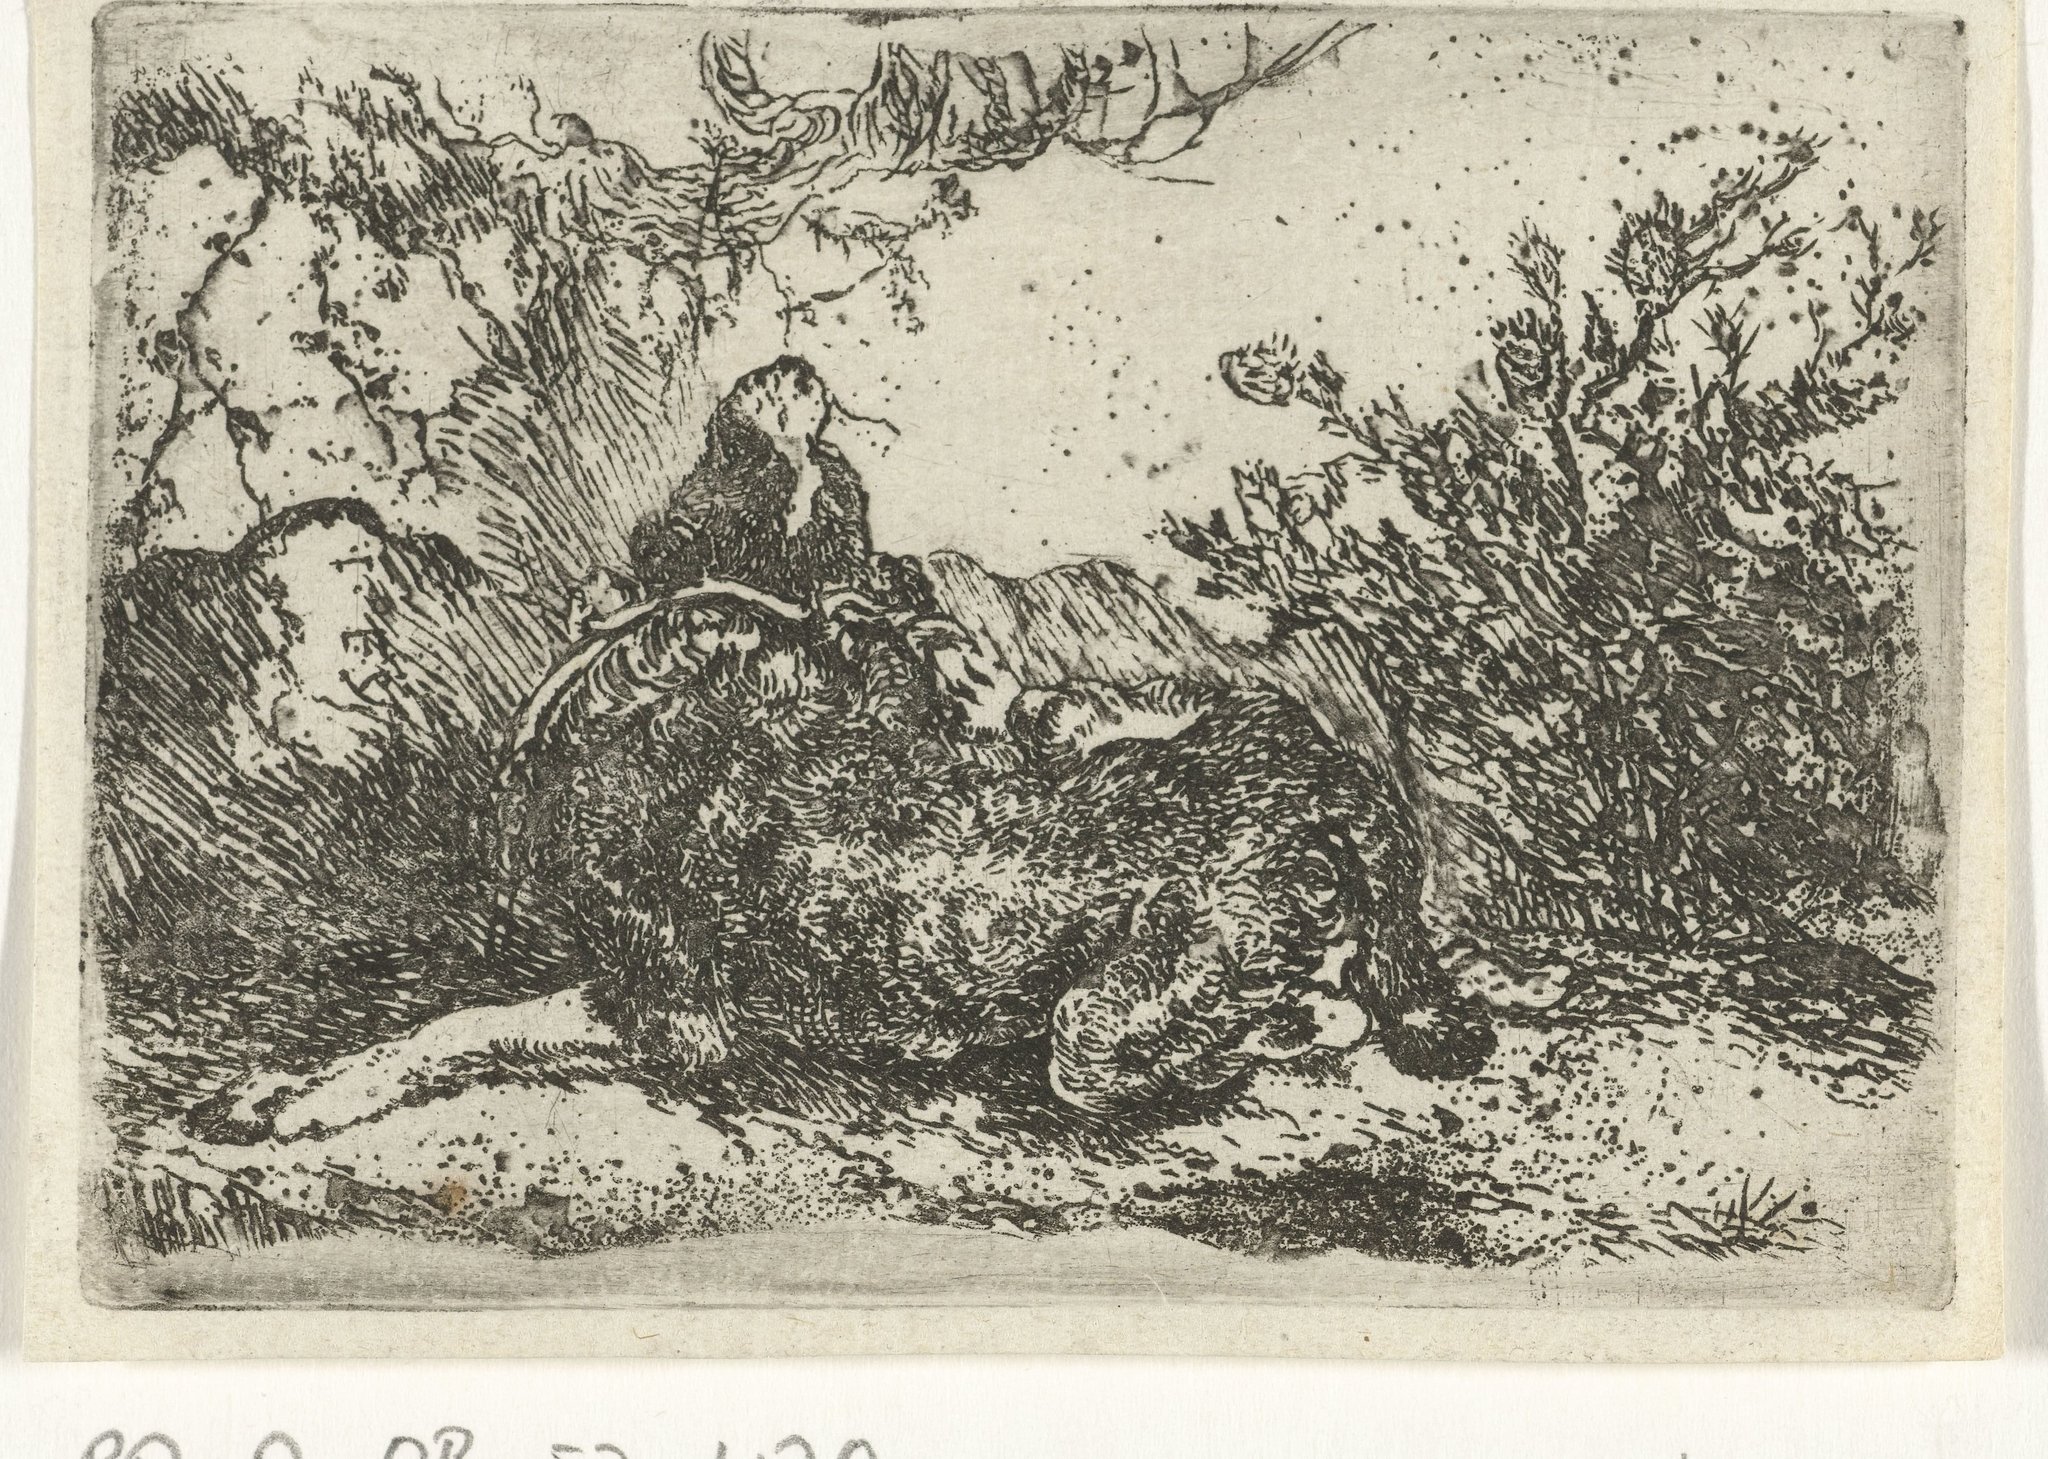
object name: print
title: Hond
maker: joannes fijt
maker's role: draughtsman, print maker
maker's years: 1611-1661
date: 1621-1661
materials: paper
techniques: etching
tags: dog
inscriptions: collector's mark: Lugt 2228